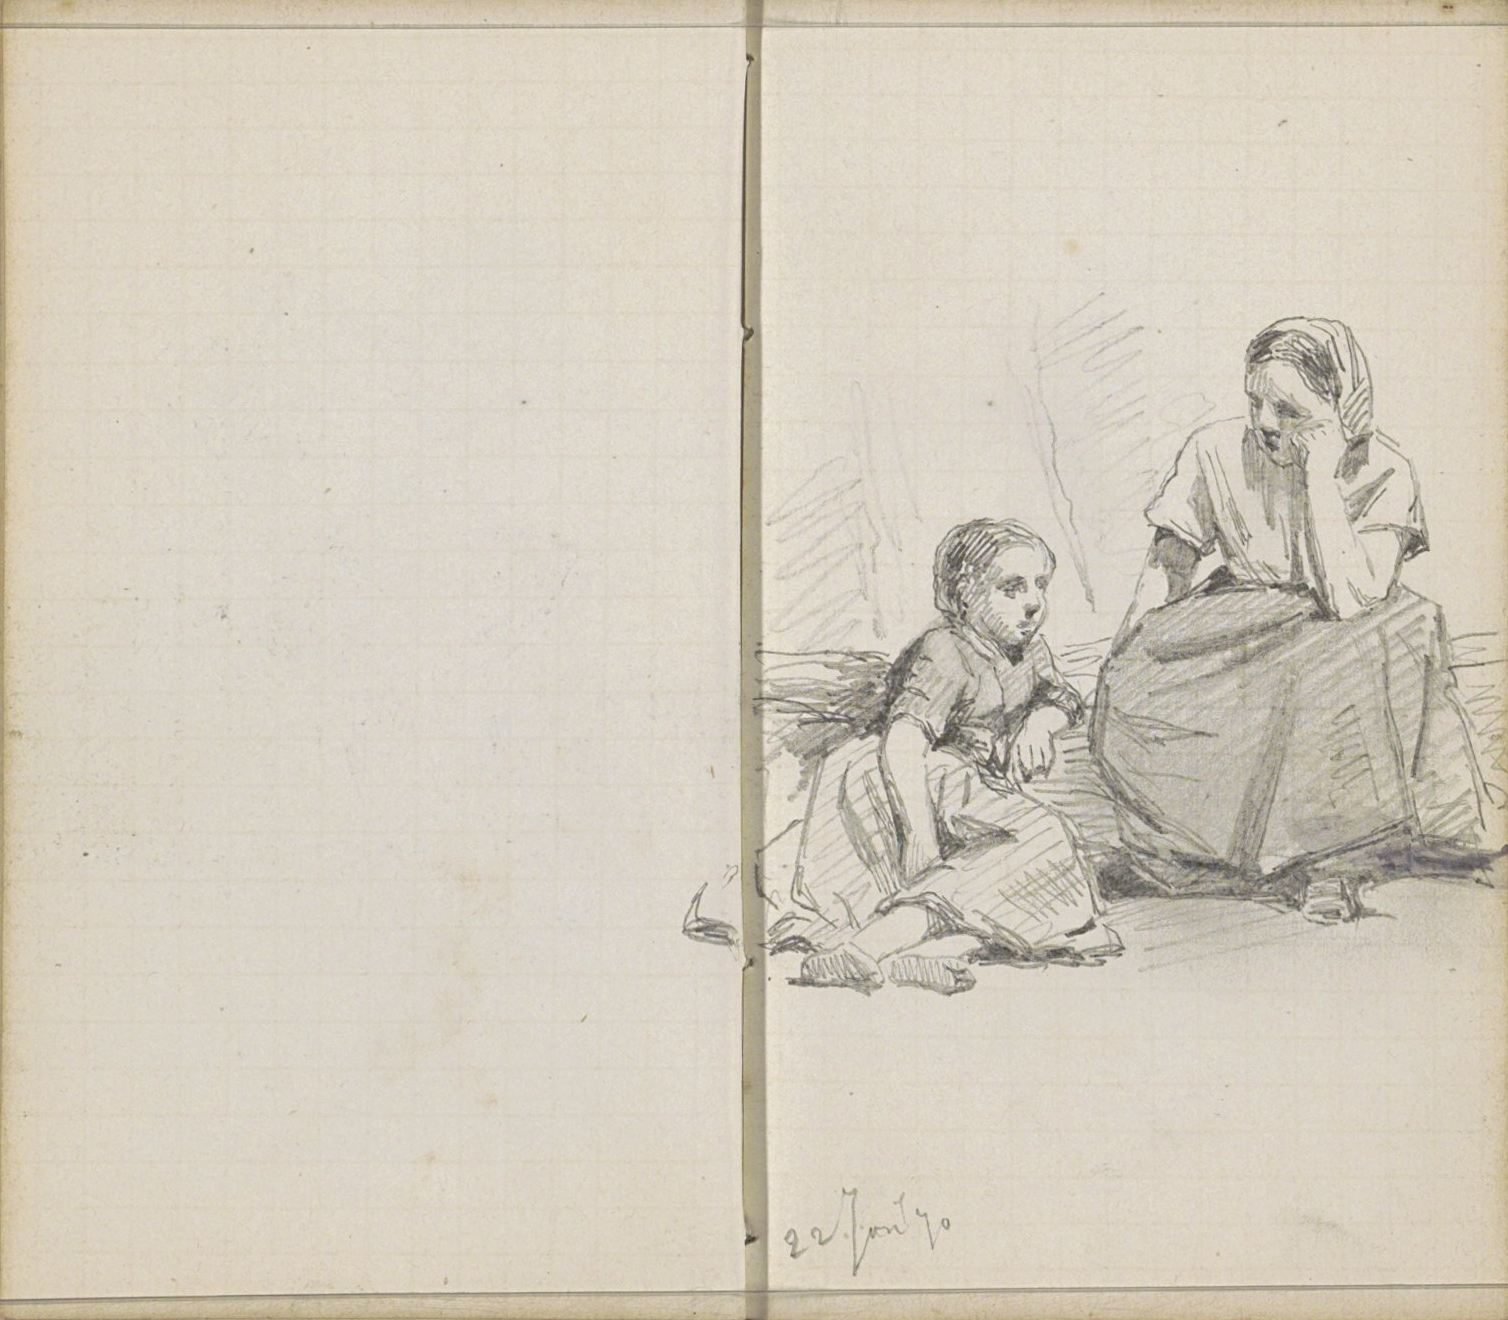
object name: sketchbook leaf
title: Twee rustende meisjes bij een boomstam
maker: jan willem van borselen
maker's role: draughtsman, print maker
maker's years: 1825-1892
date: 1801-1870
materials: pencil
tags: trees (+ stem, trunk), girl (child between toddler and youth)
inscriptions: date: ‘22 Jan 70’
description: Blad 15 verso en 16 recto uit een schetsboek met 51 bladen.